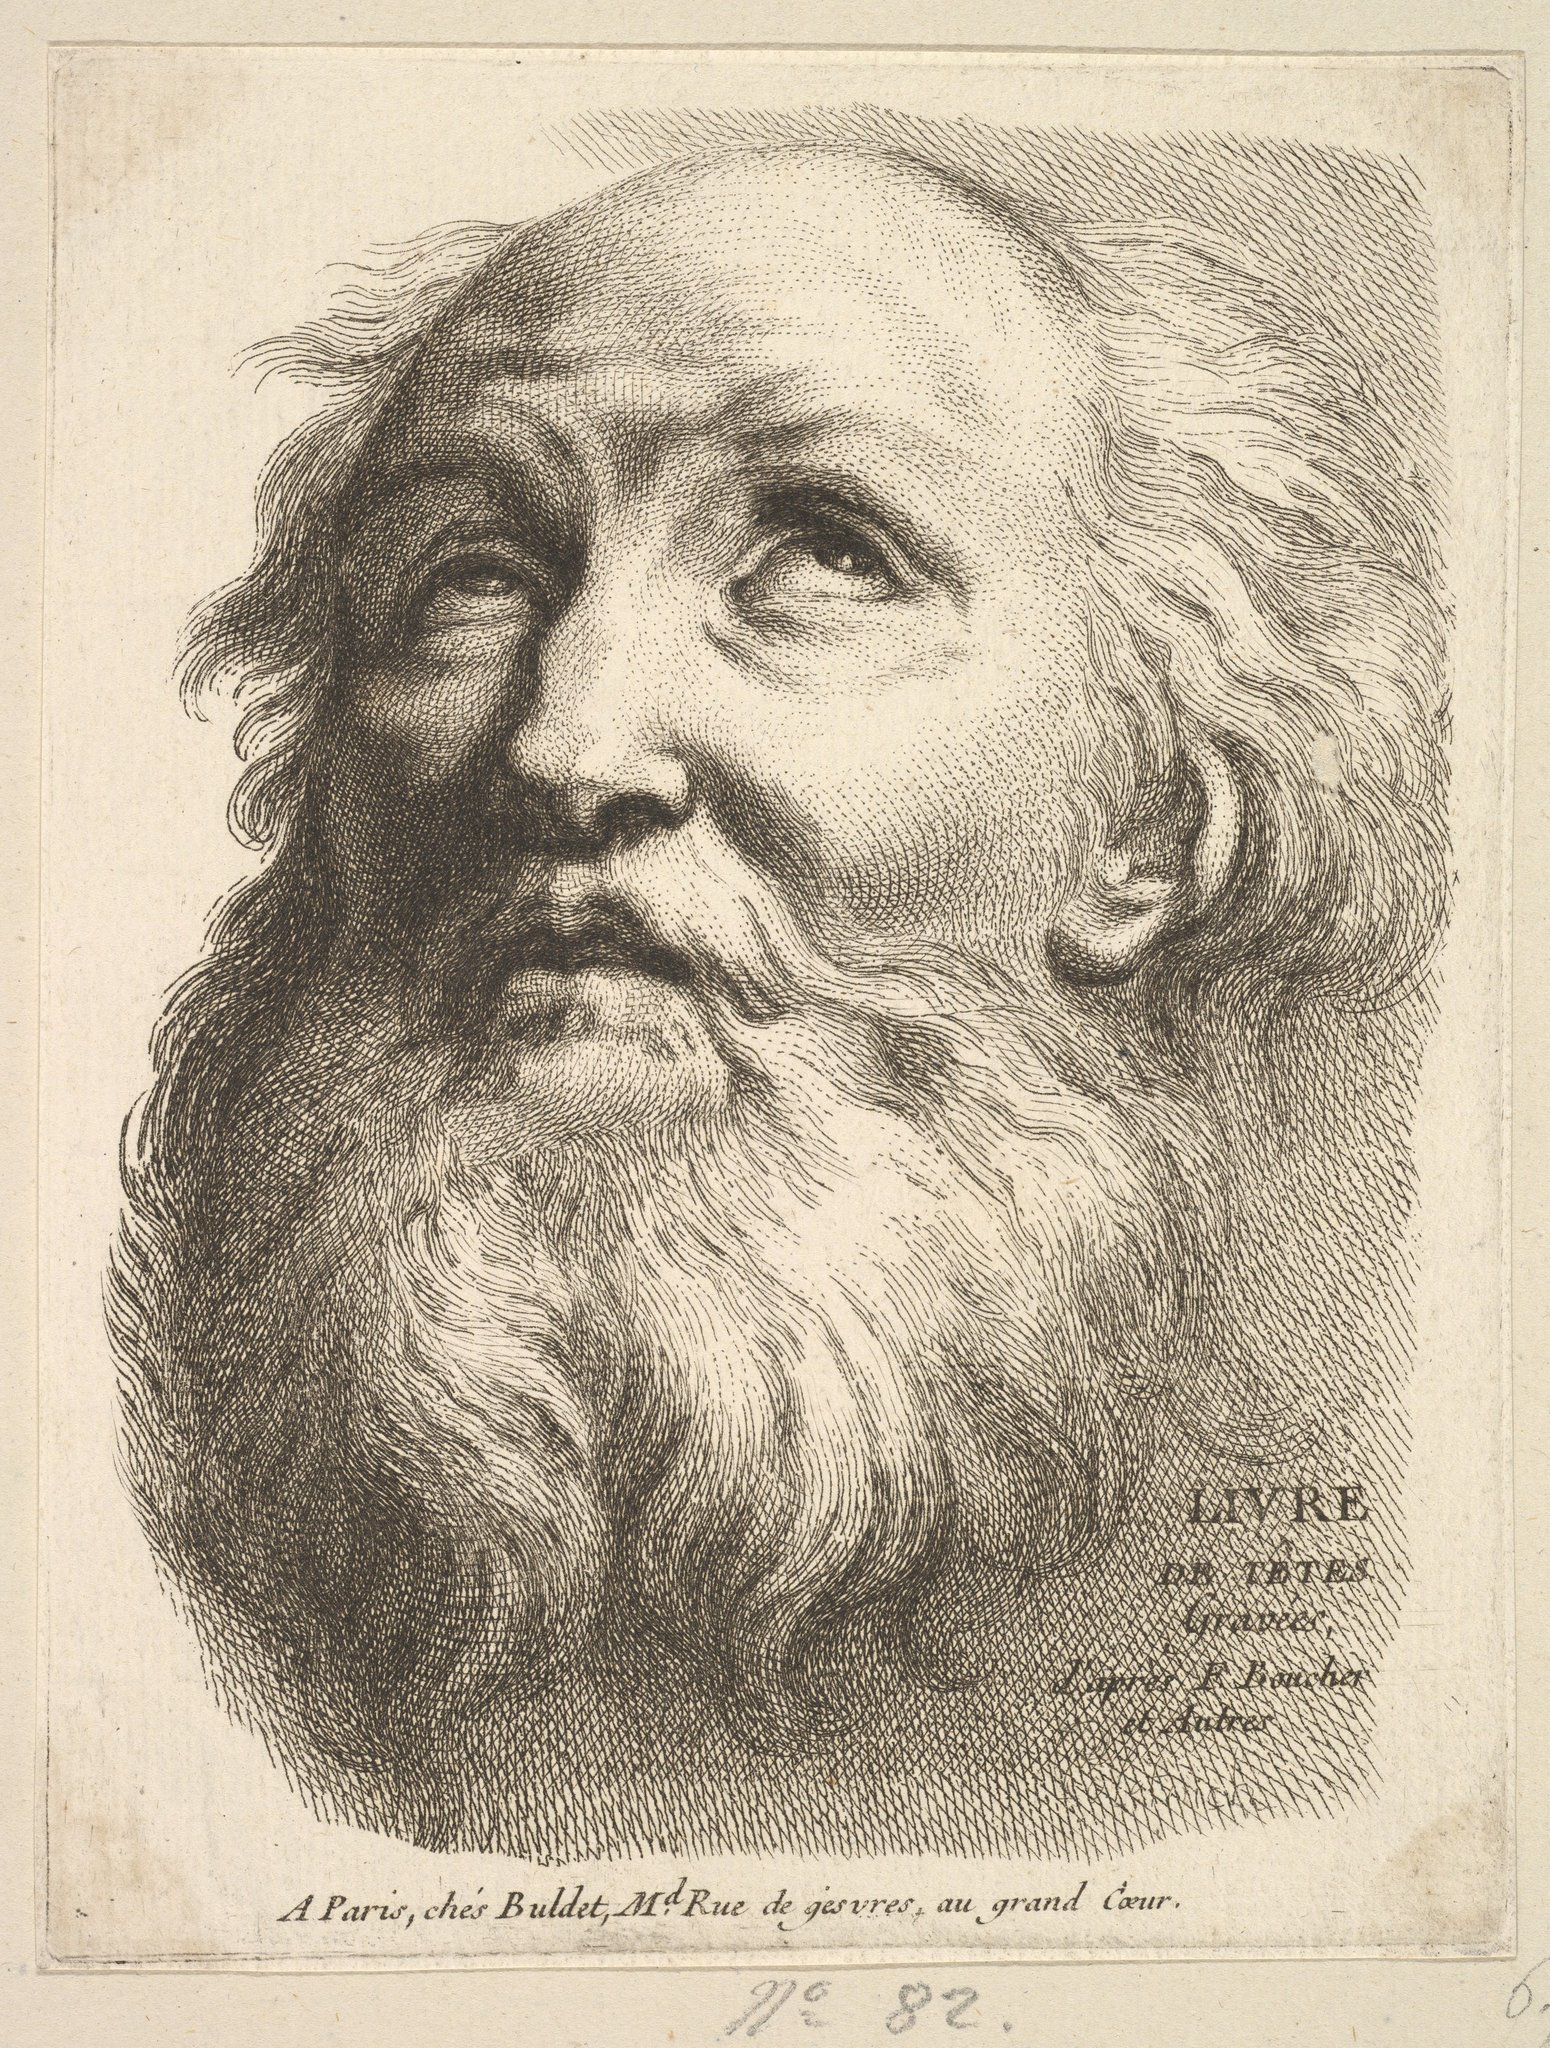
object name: print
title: Frontispiece: Head of a Bearded Man, from "Livre de Têtes Gravées d'apres F. Boucher et Autres" (Book of Heads Engraved after F. Boucher and Others)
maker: anonymous, french, 18th century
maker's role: artist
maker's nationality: french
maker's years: 1700-1800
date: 1701-1800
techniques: engraving, etching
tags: heads,men